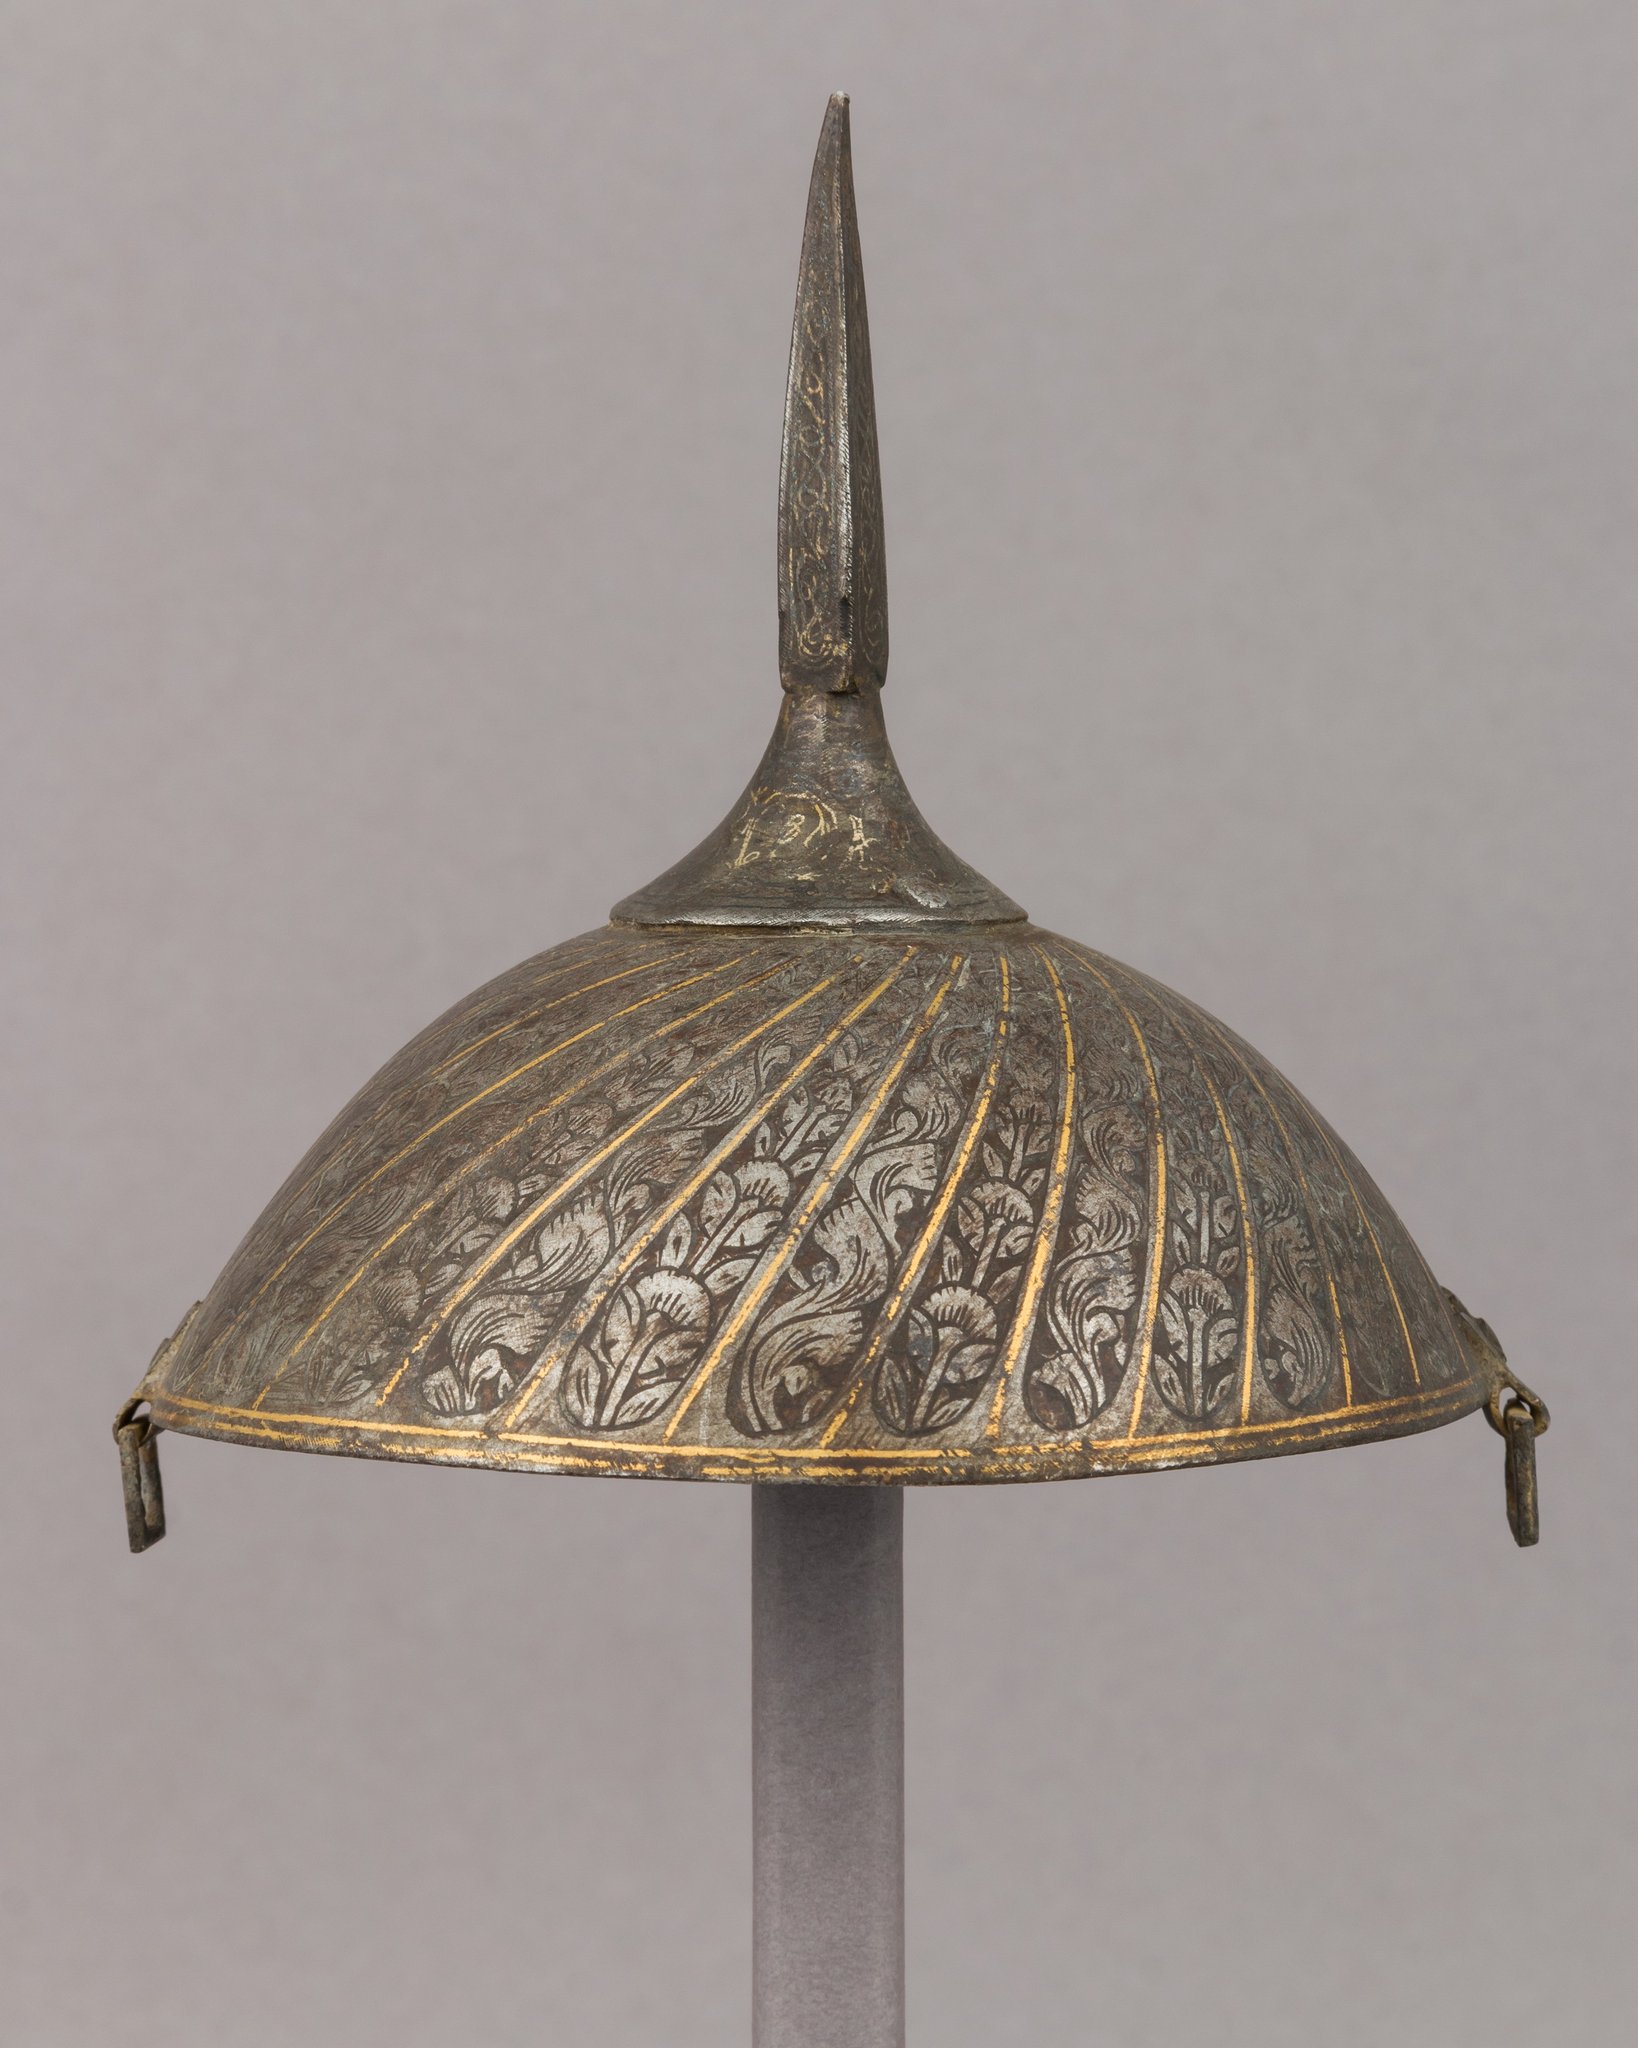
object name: helmet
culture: indian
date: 1801-1900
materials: gold, steel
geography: north india